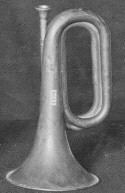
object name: post horn in b flat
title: Post Horn in B-flat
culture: european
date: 1801-1900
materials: brass